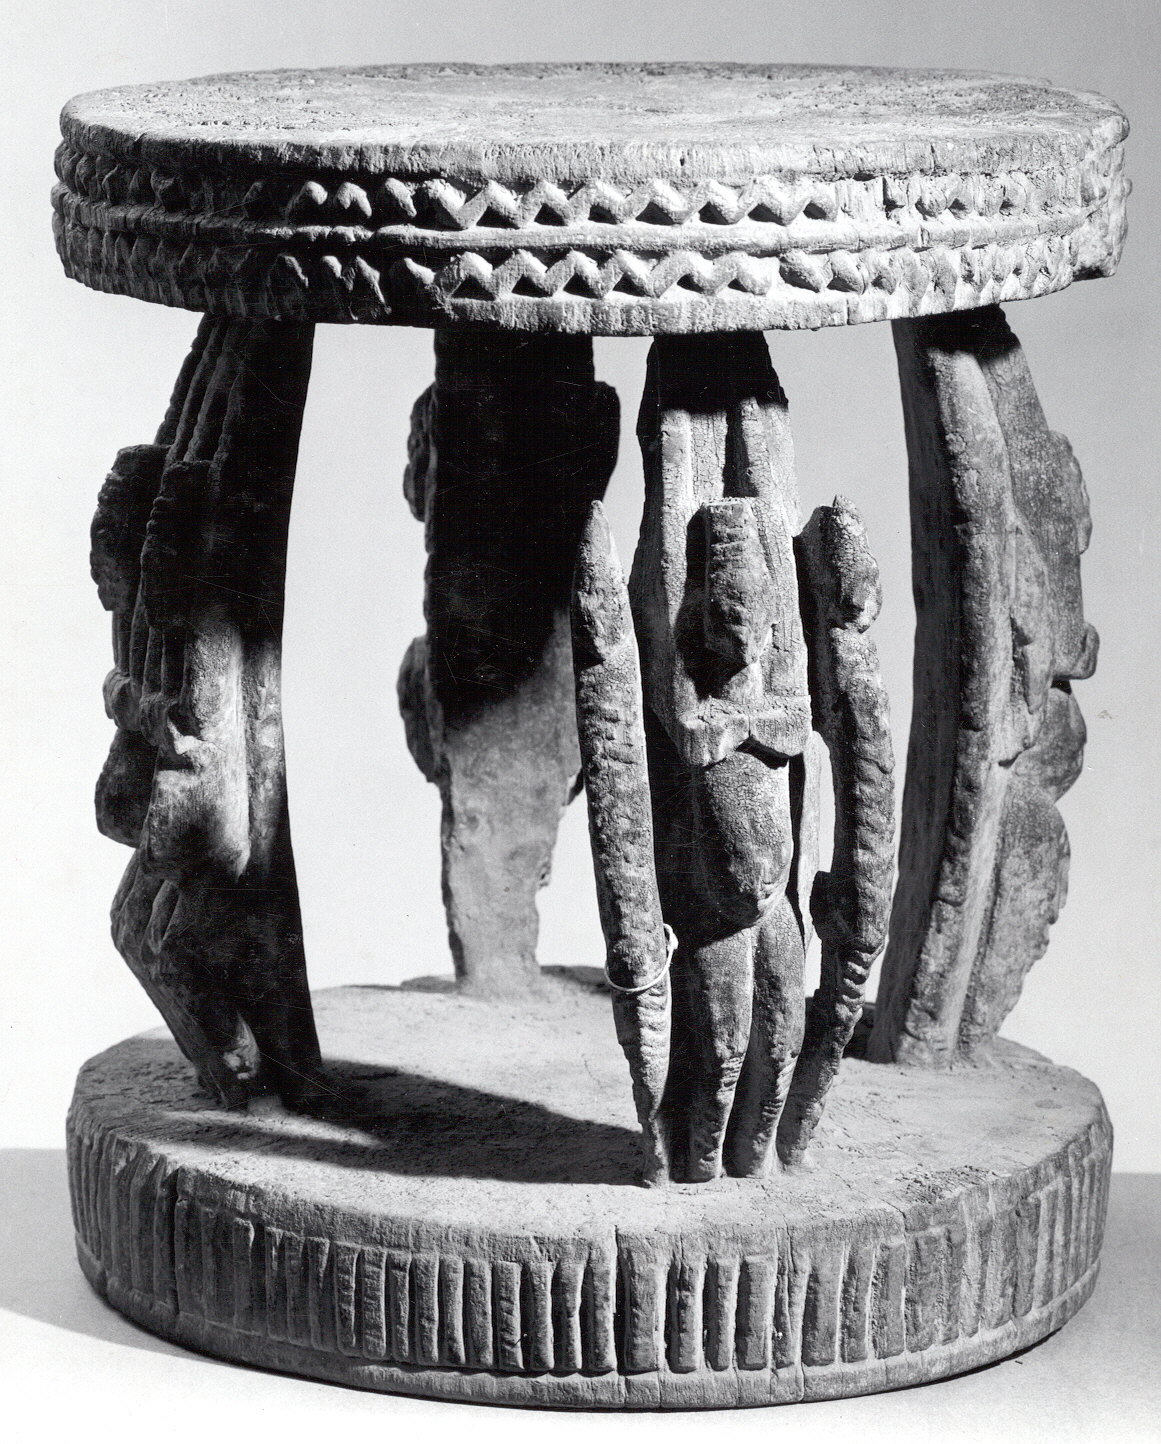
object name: stool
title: Prestige Stool: Figures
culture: dogon or tellem peoples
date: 1401-1900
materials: patina, wood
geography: mali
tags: human figures